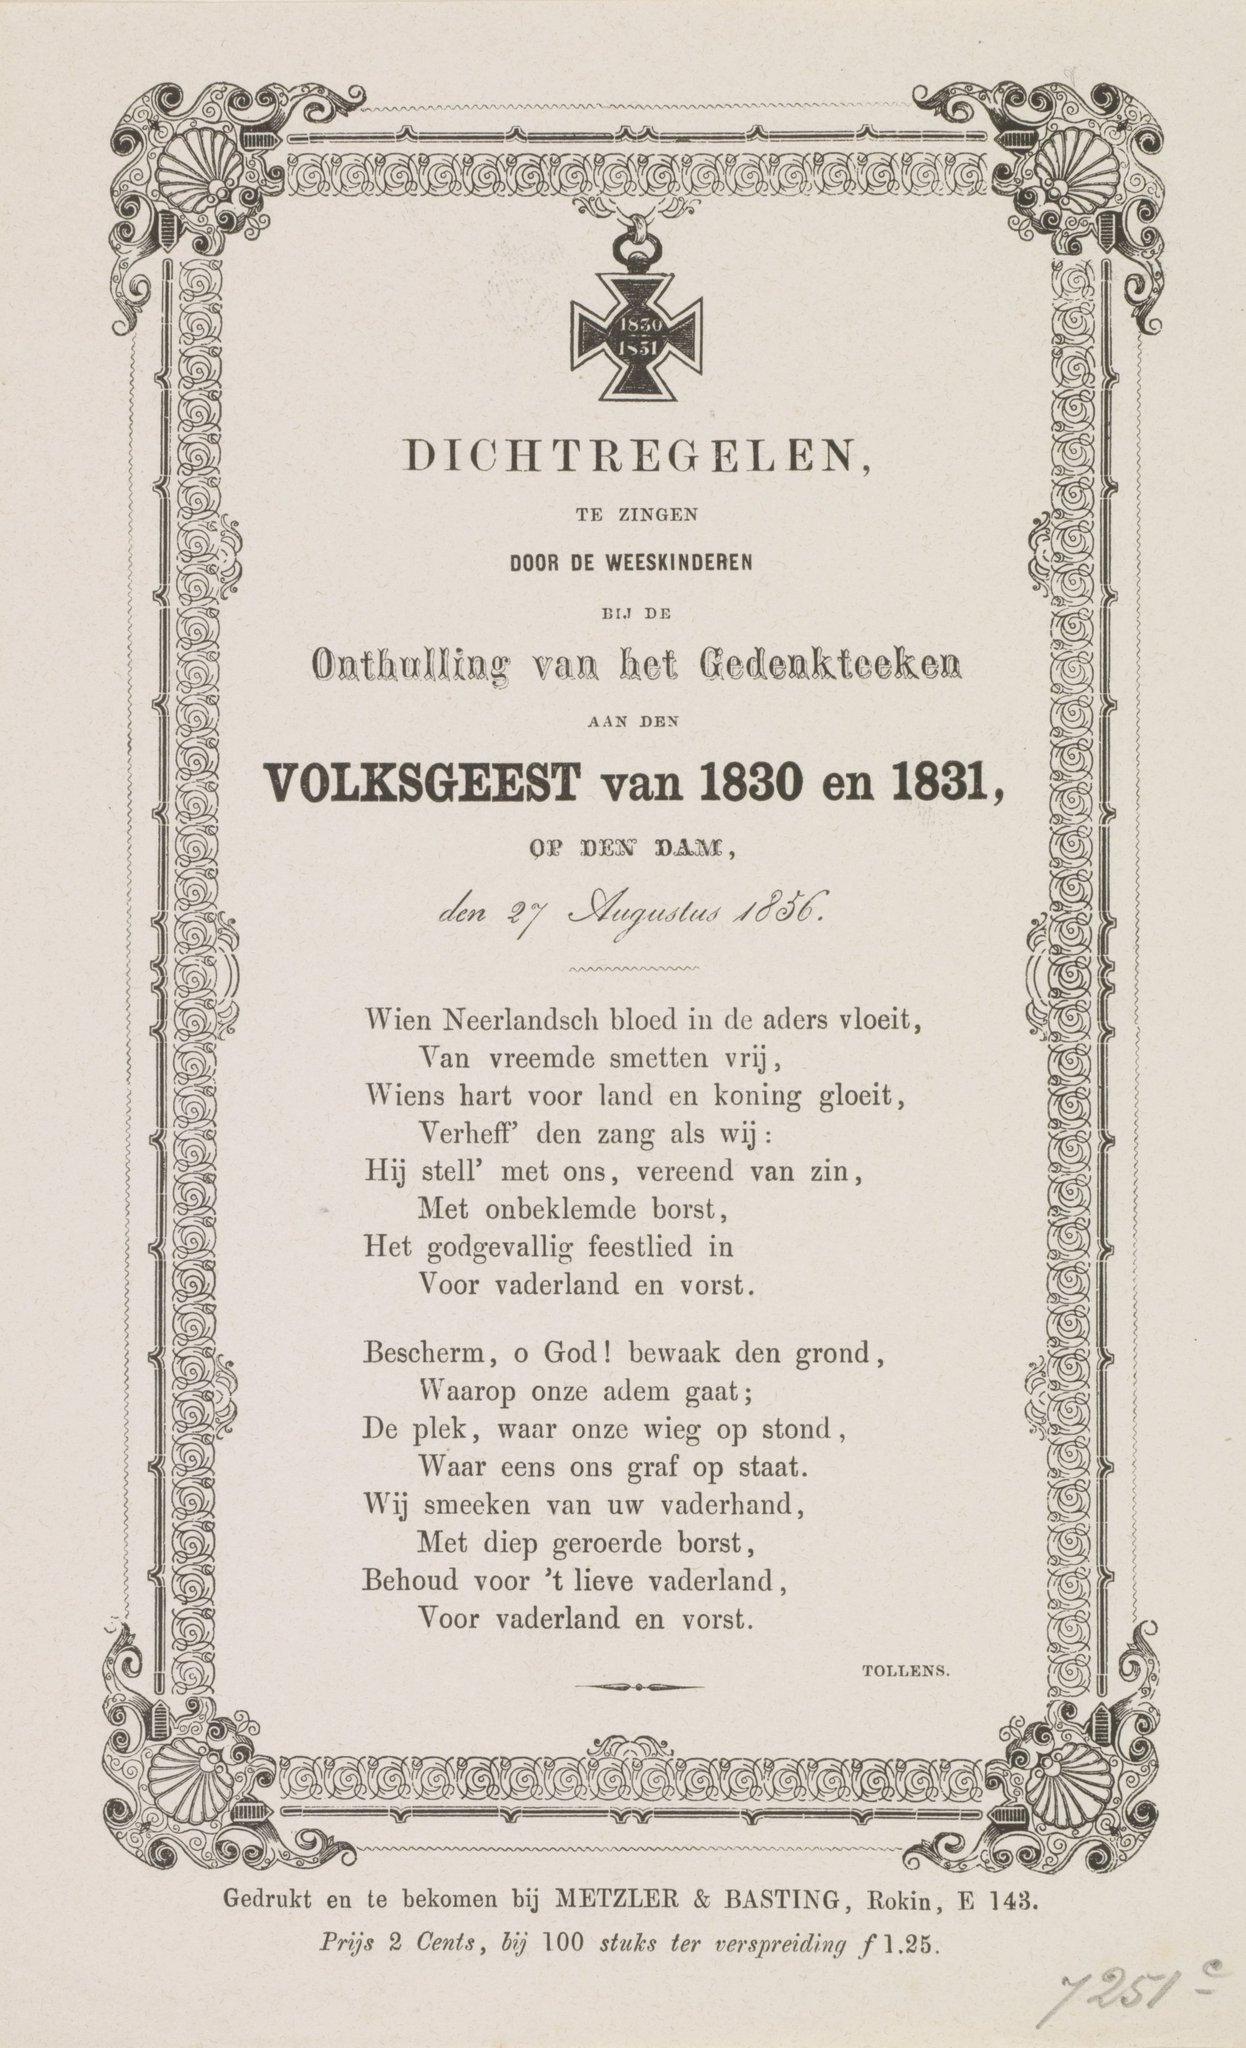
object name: text sheet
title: Dichtregelen, te zingen door de weeskinderen bij de Onthuling van het Gedenkteeken aan den Volksgeest van 1830 en 1831, op den Dam, den 27 Augustus 1856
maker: hendrik tollens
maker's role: dichter, schrijver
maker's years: 1780-1856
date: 1856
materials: paper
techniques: letterpress printing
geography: amsterdam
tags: dam, naatje op de dam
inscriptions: collector's mark: Lugt 2228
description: Tekstblad met de eerste en vijfde coupletten van Tollens' lied Wien Neêrlands bloed, door de weeskinderen te zingen tijdens de onthulling van het monument Gedenkteken aan de Volksgeest van 1830 en 1831, bekend als Naatje op de Dam, onthuld te Amsterdam op 27 augustus 1856. Tekst binnen een ornamentele omlijsting, bovenaan het Metalen Kruis.